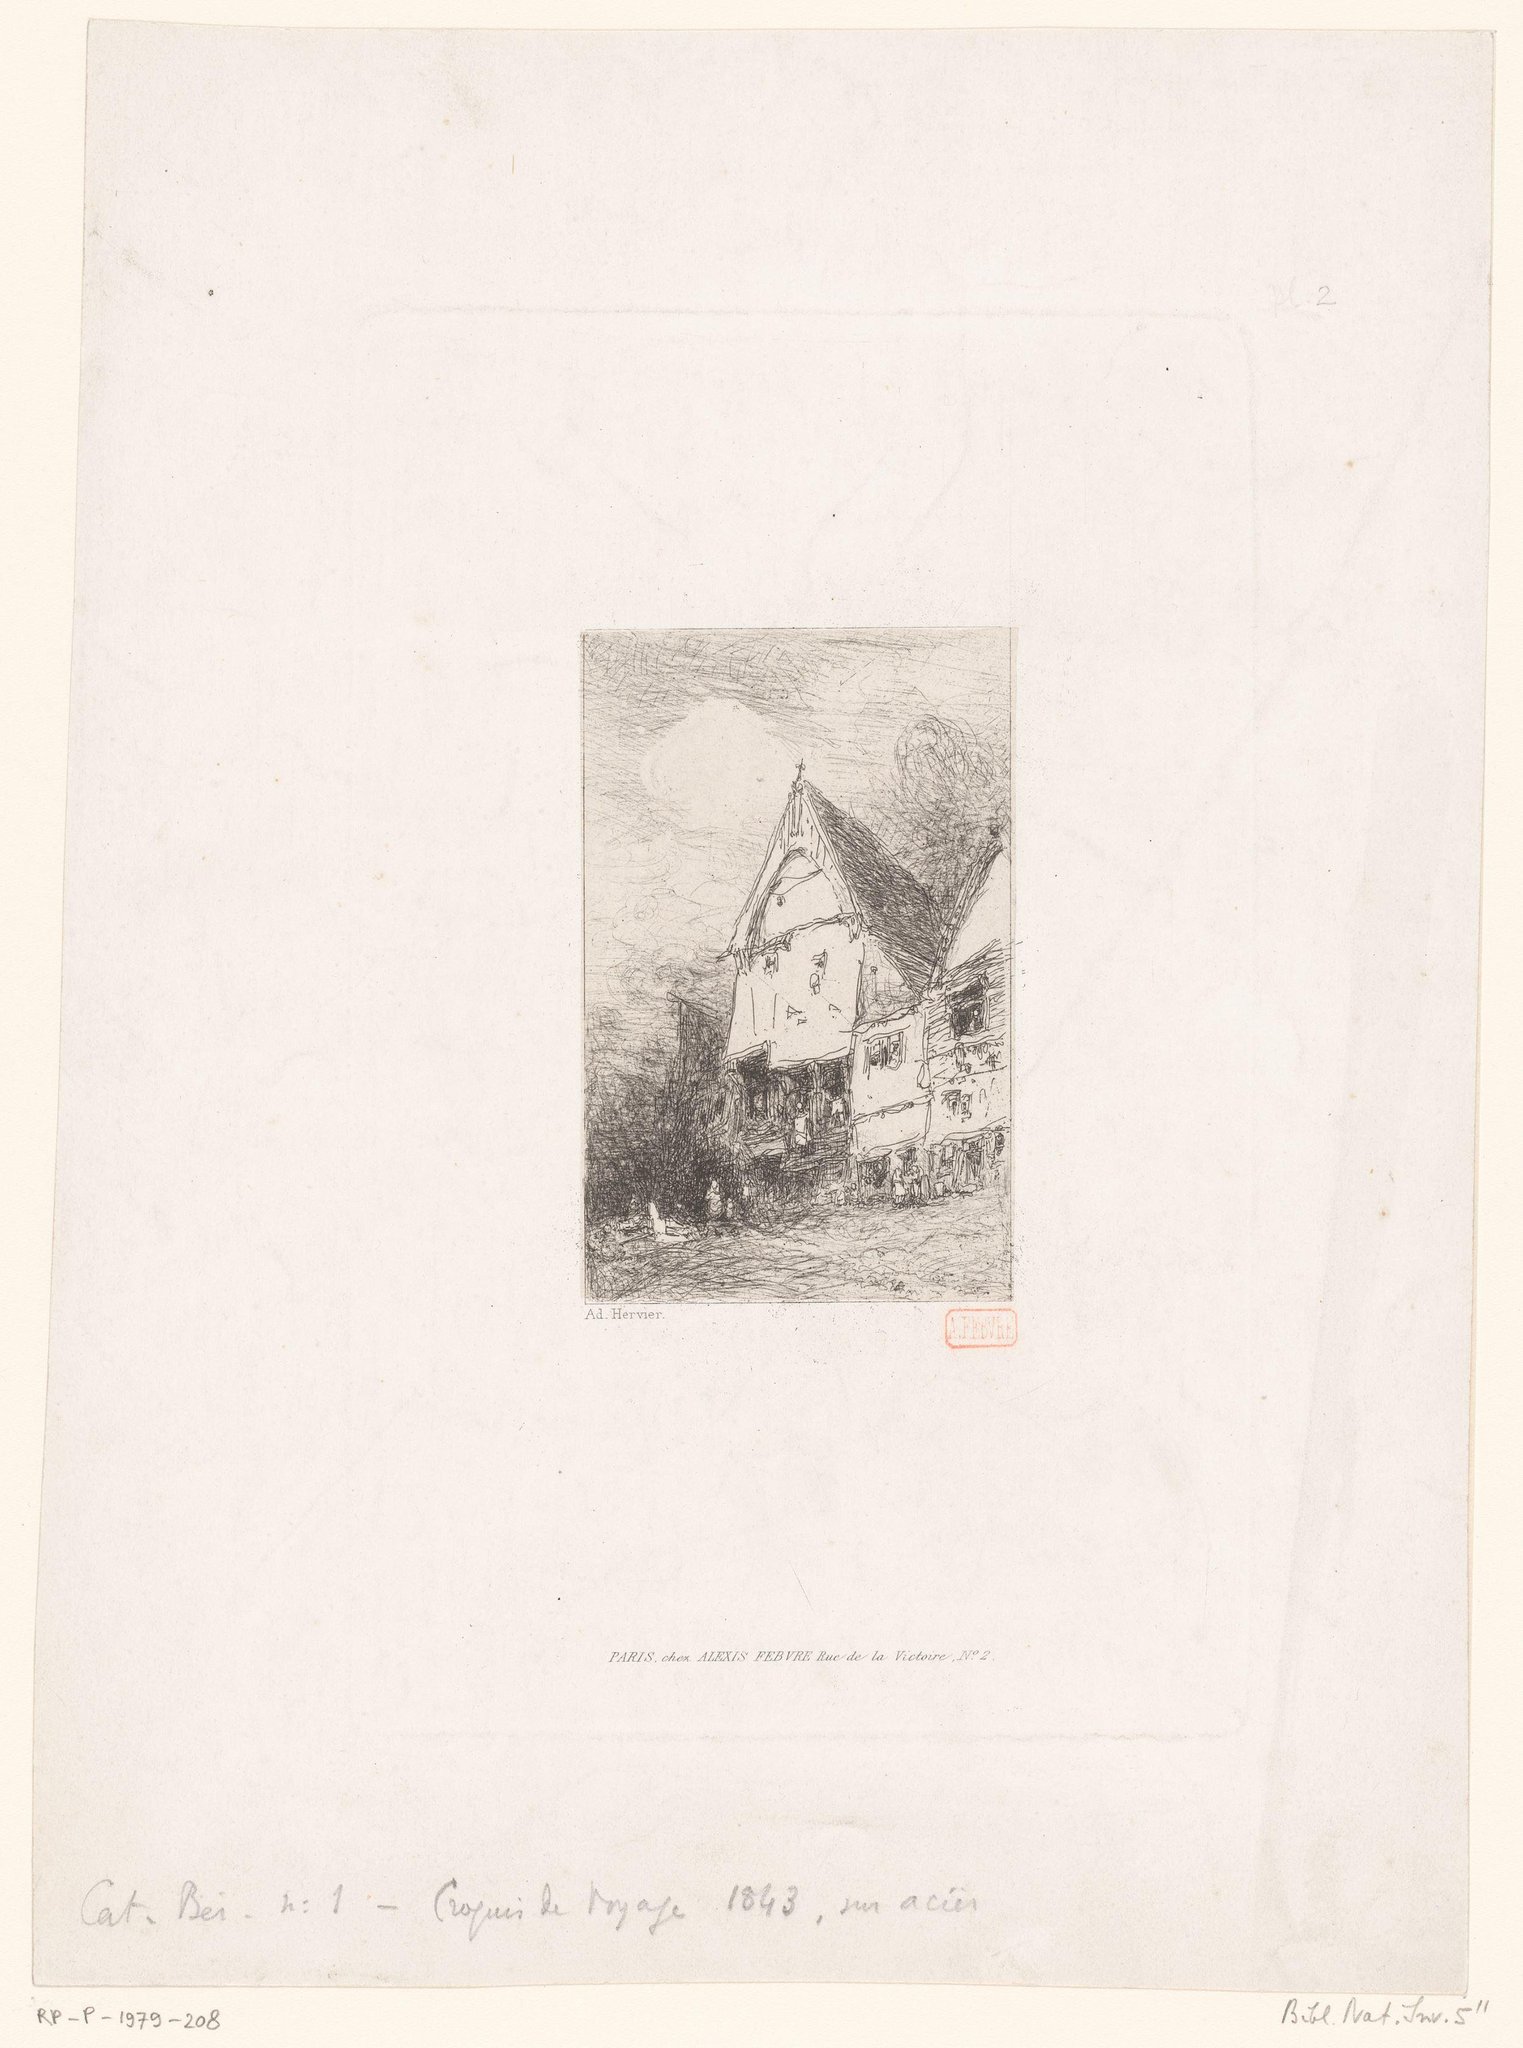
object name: print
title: Verschillende landschappen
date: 1843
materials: paper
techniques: etching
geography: paris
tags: rural housing, e.g. country-house, villa, cottage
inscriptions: collector's mark: Lugt 2228, collector's mark: Lugt 2760, stamp: Lugt 922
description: Maakt deel uit van een achtdelige serie met landschappen uit 1843.